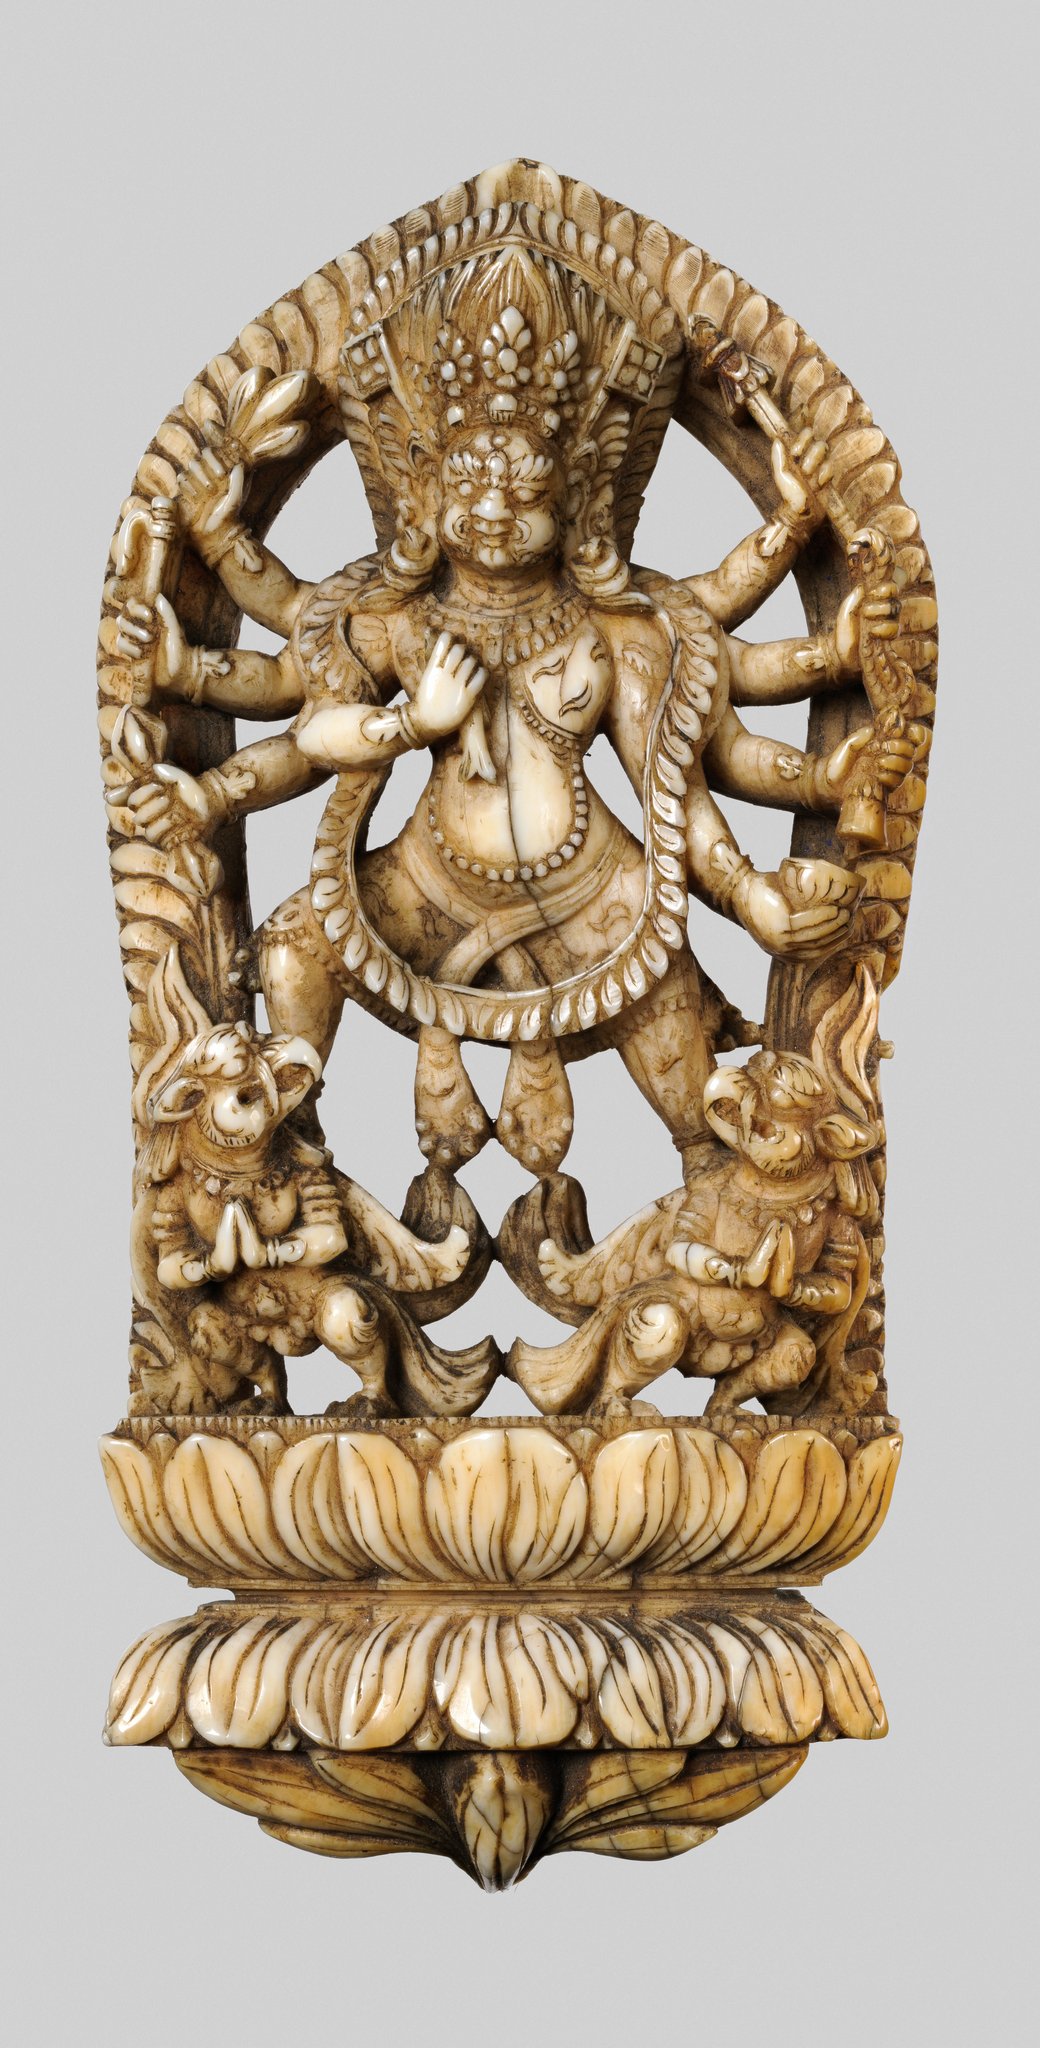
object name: figure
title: Wrathful Eight-Armed Deity with Bird Attendants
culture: nepali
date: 1501-1700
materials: ivory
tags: birds,hands,mythical creatures,lotuses